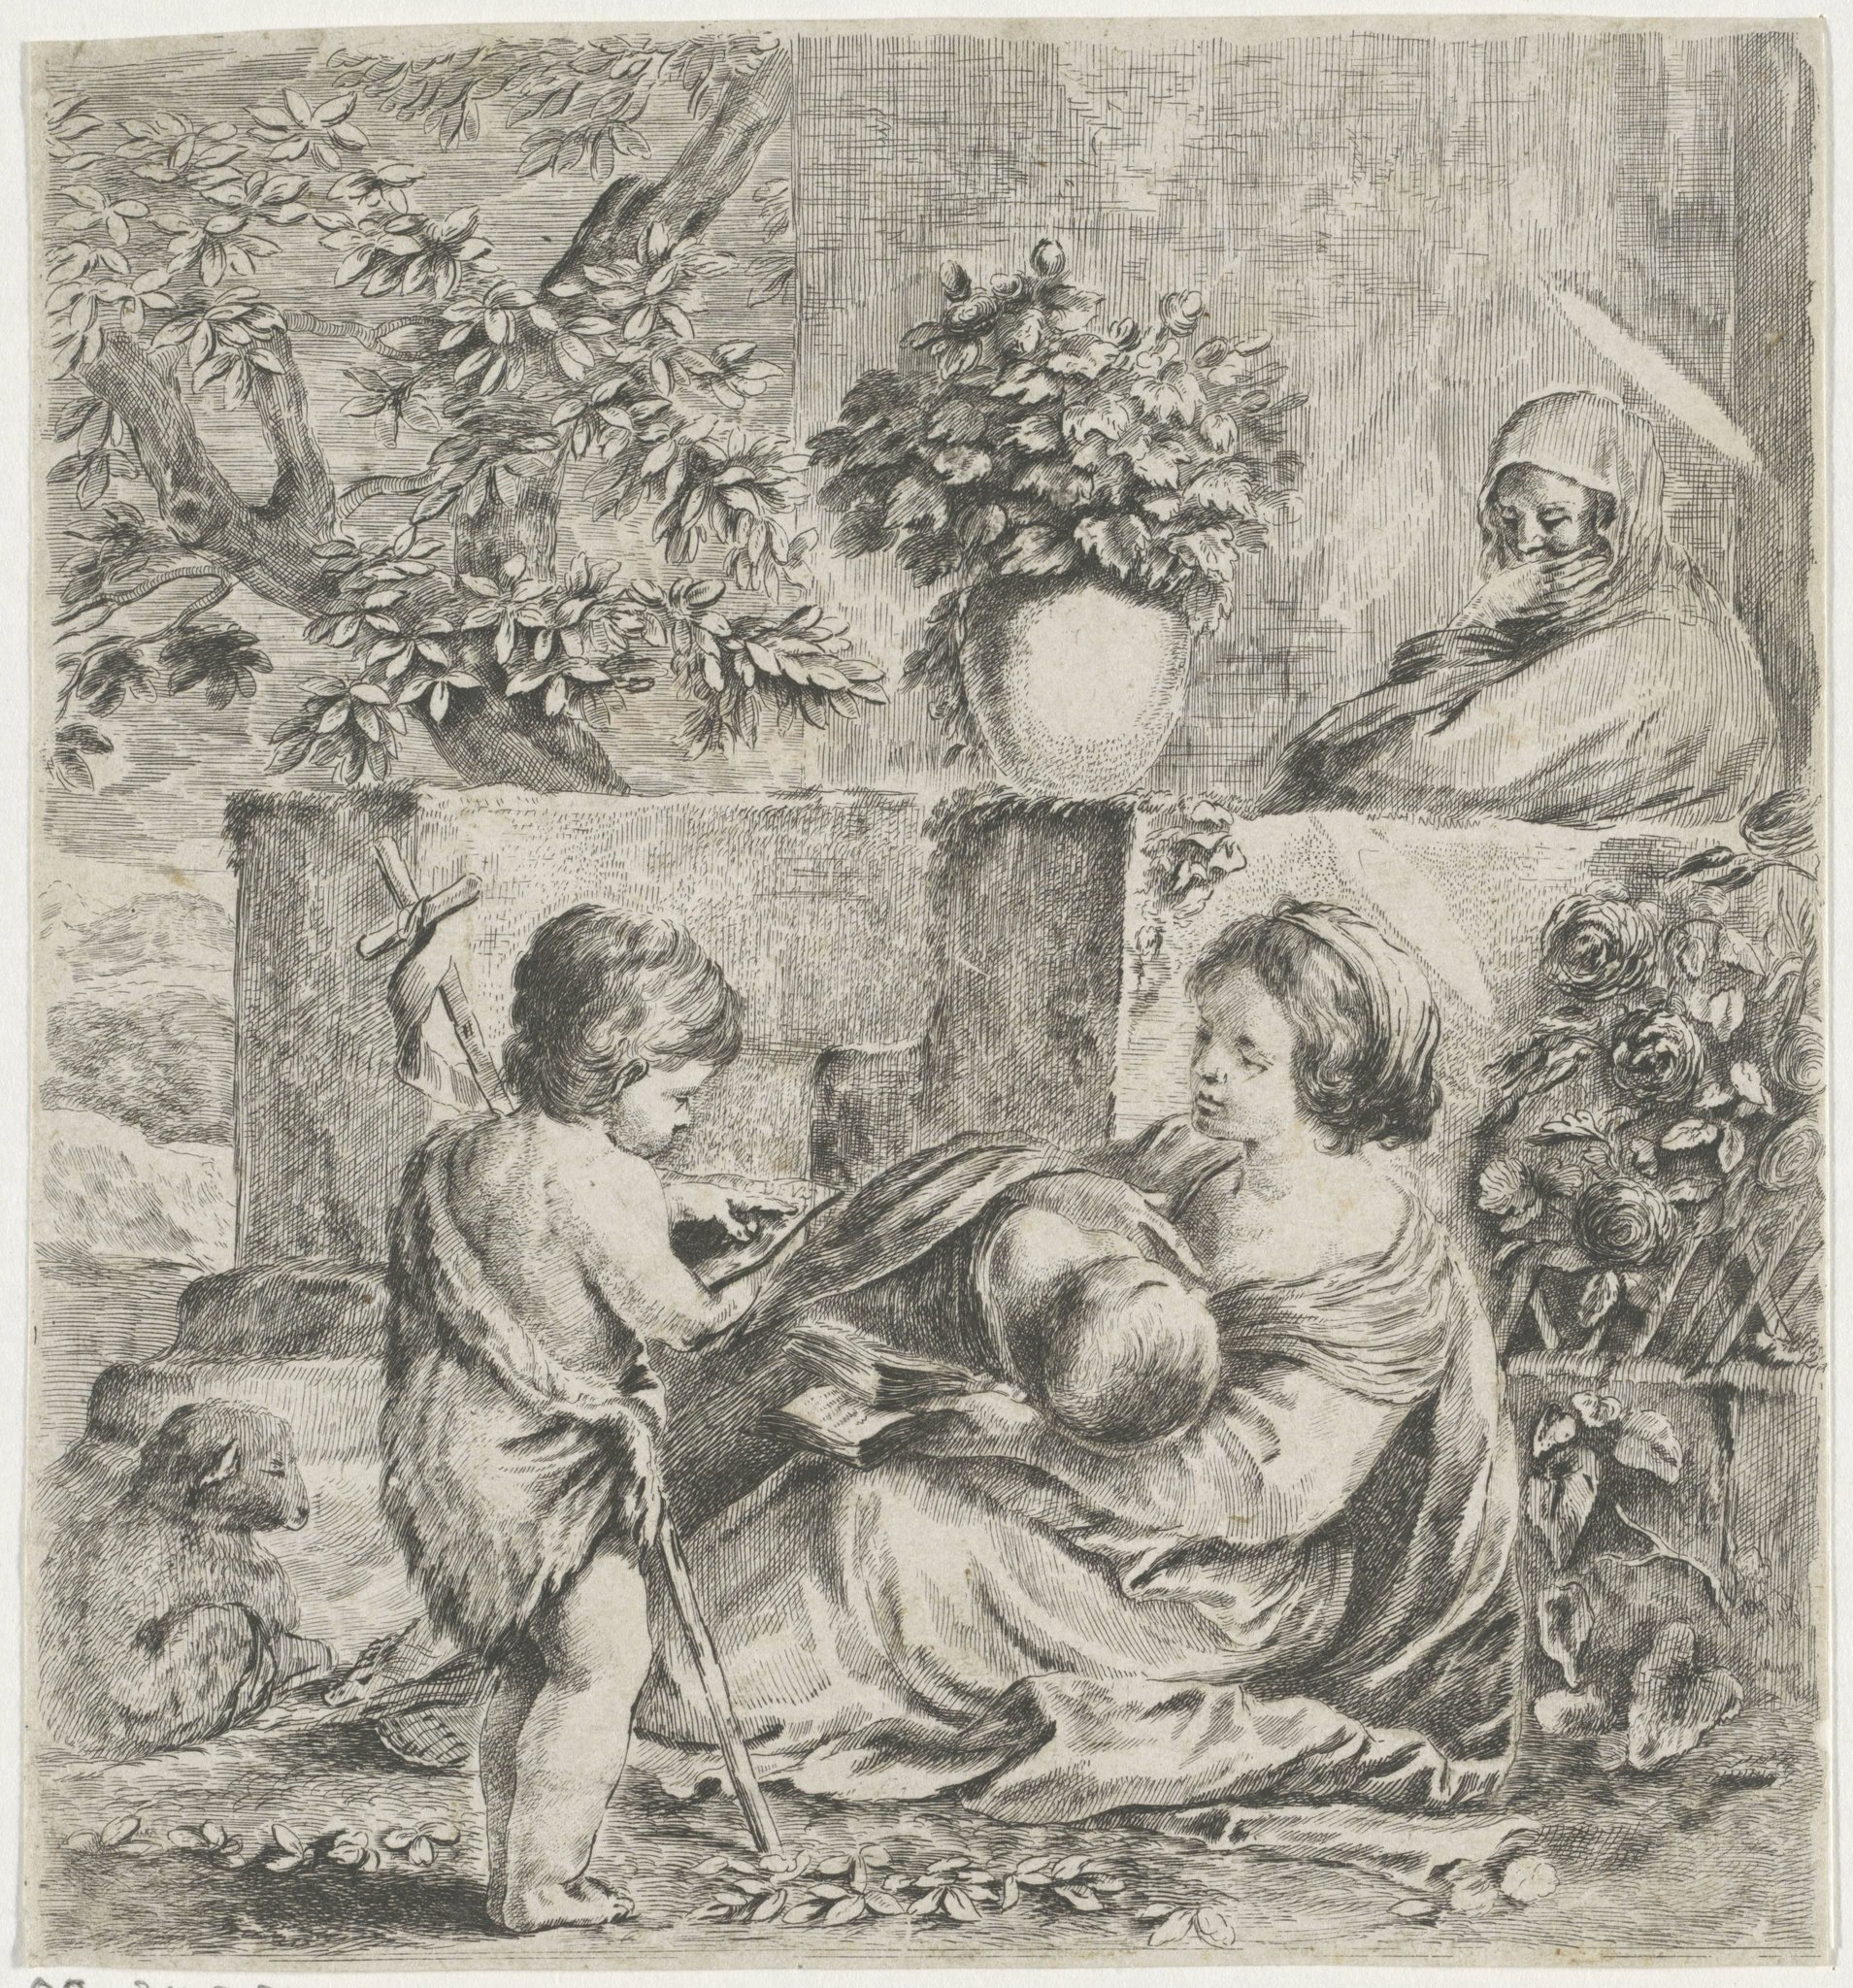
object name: print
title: Maria met Kind, de jonge Johannes de Doper en de heilige Elisabet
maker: Anonymous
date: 1620-1664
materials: paper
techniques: etching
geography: italy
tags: mary, the christ-child and john the baptist, elisabeth present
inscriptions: collector's mark: Lugt 2228, collector's mark: Lugt 240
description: Maria zit op de grond en zoogt het Christuskind. Voor haar staat de jonge Johannes de Doper met zijn lam. Op de achtergrond zit de heilige Elisabet.